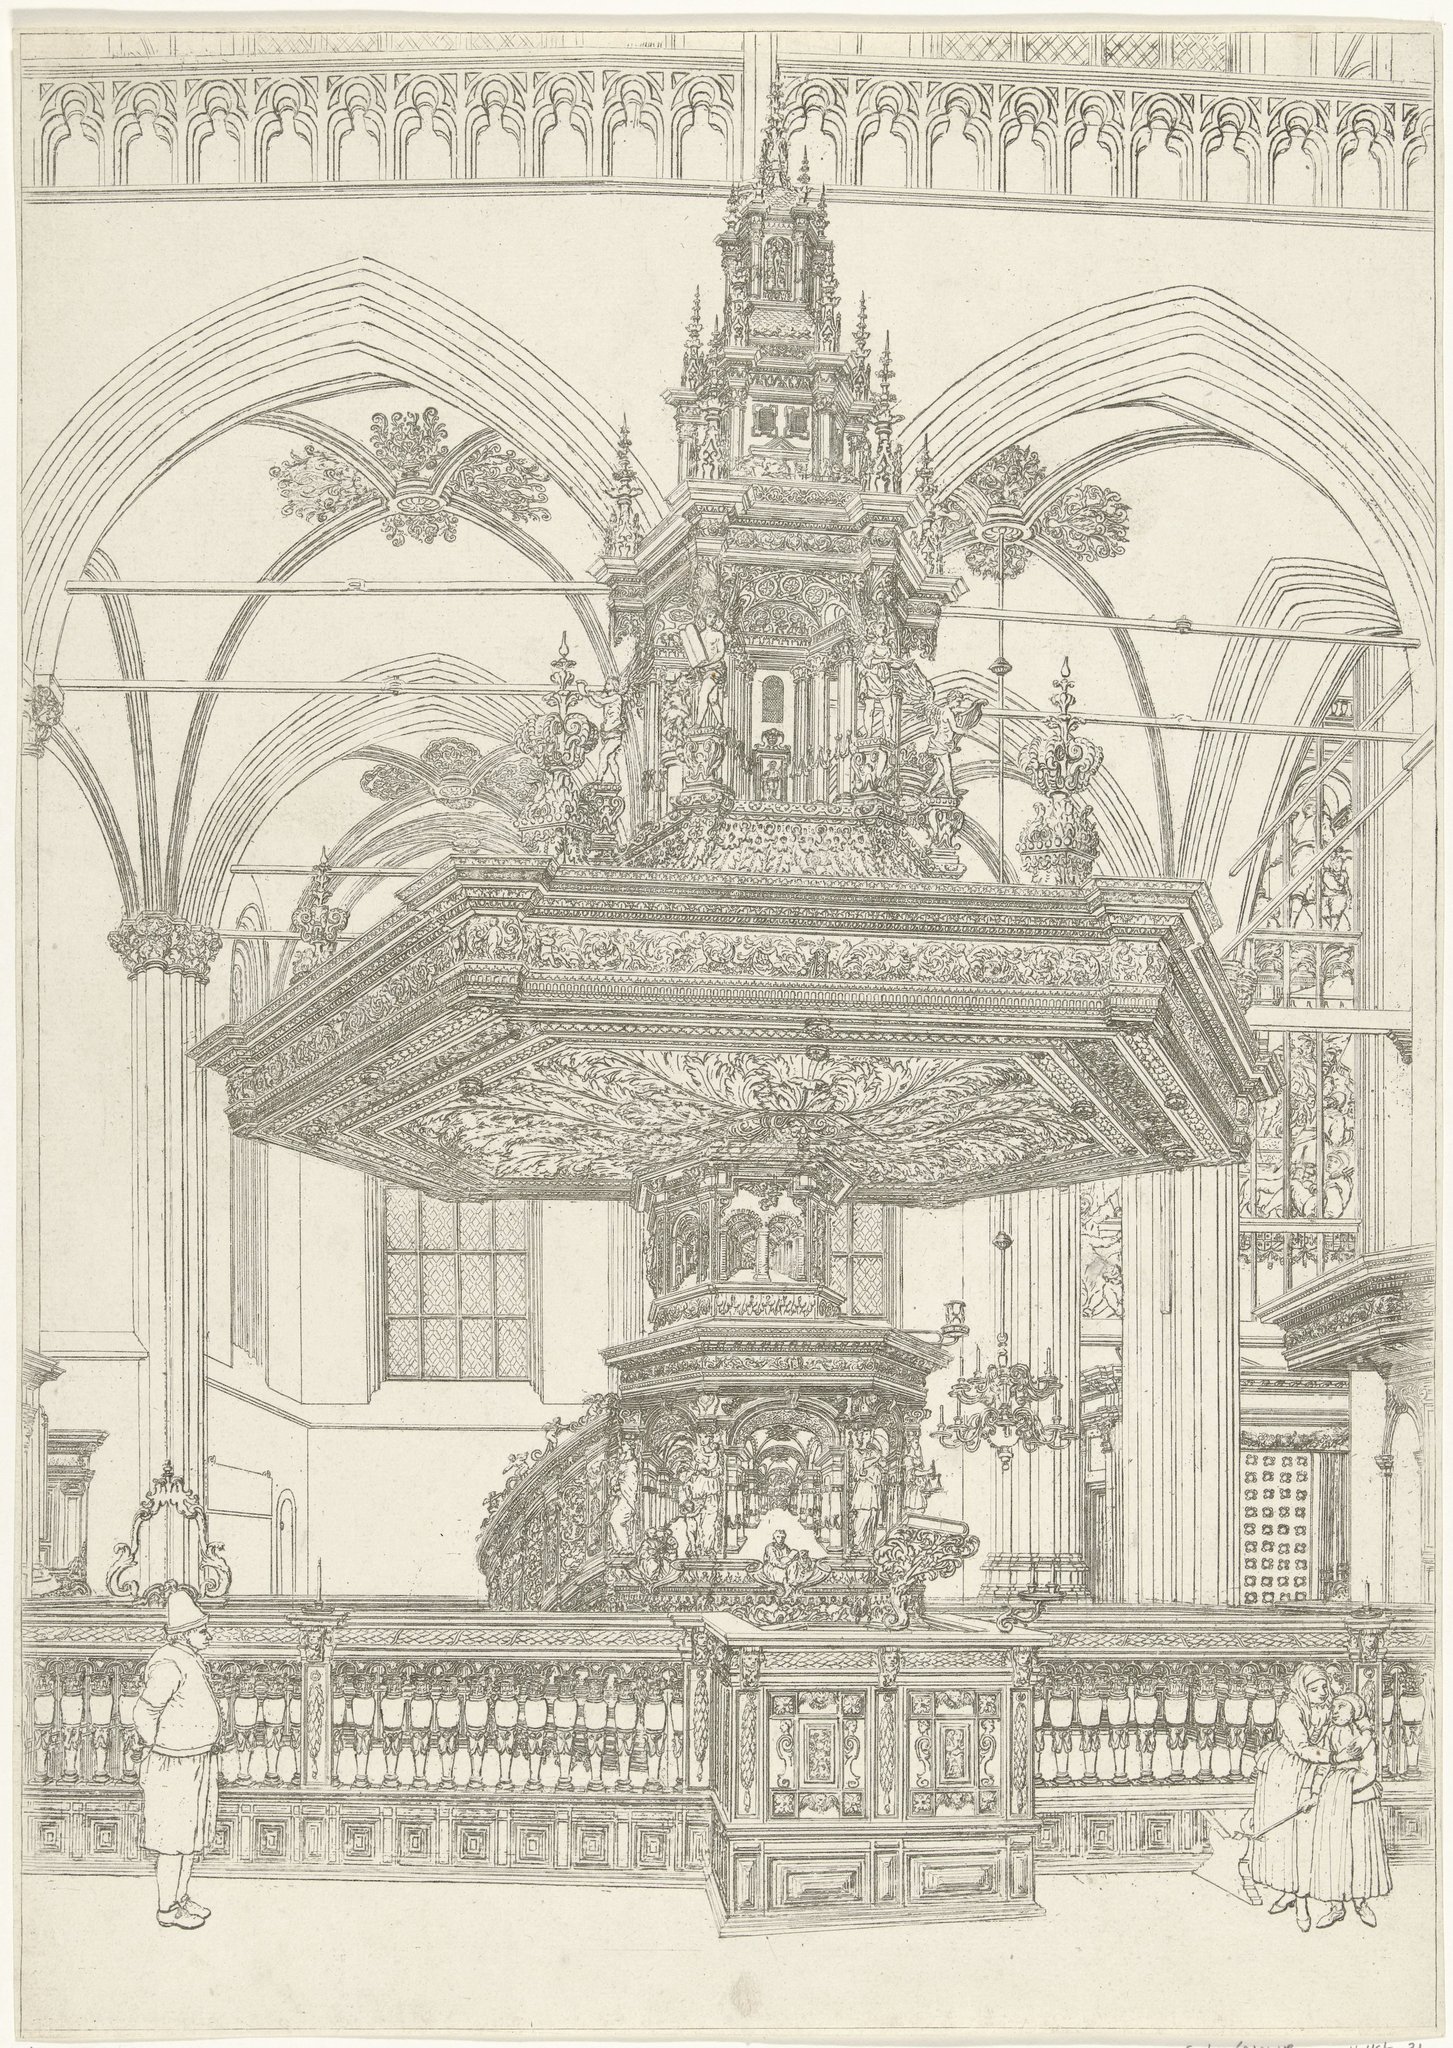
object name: print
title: Preekstoel in de Nieuwe Kerk in Amsterdam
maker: pieter holsteyn (ii)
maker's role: draughtsman, print maker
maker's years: 1614-1673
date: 1649-1673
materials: paper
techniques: printmaking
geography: northern netherlands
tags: amsterdam, sculptor, albert jansz vinckenbrinck, interior of church, pulpit, ambo, chancel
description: Na de brand van 1645 kreeg beeldhouwer Albert Jansz. Vinckenbrinck opdracht voor het maken van een nieuwe preekstoel voor de Nieuwe Kerk. Bekend is dat hij van 1649 tot 1664 werkte aan deze preekstoel. In de collectie van het Stadsarchief Amsterdam bevindt tegendruk van deze ets die met zwarte inkt is ingekleurd en bijgewerkt. Op dit exemplaar staat linksonder 'J. v.d. Heyden, anno 1649' geschreven. De naam van Van der Heyden zorgt voor verwarring rondom het auteurschap van deze prent, die is geëtst door Pieter Holsteyn (II). Ook het jaartal 1649 is verwarrend, aangezien de preekstoel toen nog niet klaar was. Als het jaartal en de naam daadwerkelijk in 1649 op deze prent zijn geschreven is het aannemelijk dat een J. van der Heyden in 1649 zijn naam heeft gezet op een door hem ingekleurde tegendruk van de door Pieter Holsteyn (II) gemaakte prent. Dat dit al in 1649 was impliceert dat de prent is gemaakt naar een ontwerp van de preekstoel, die in de daaropvolgende jaren gerealiseerd zou worden.